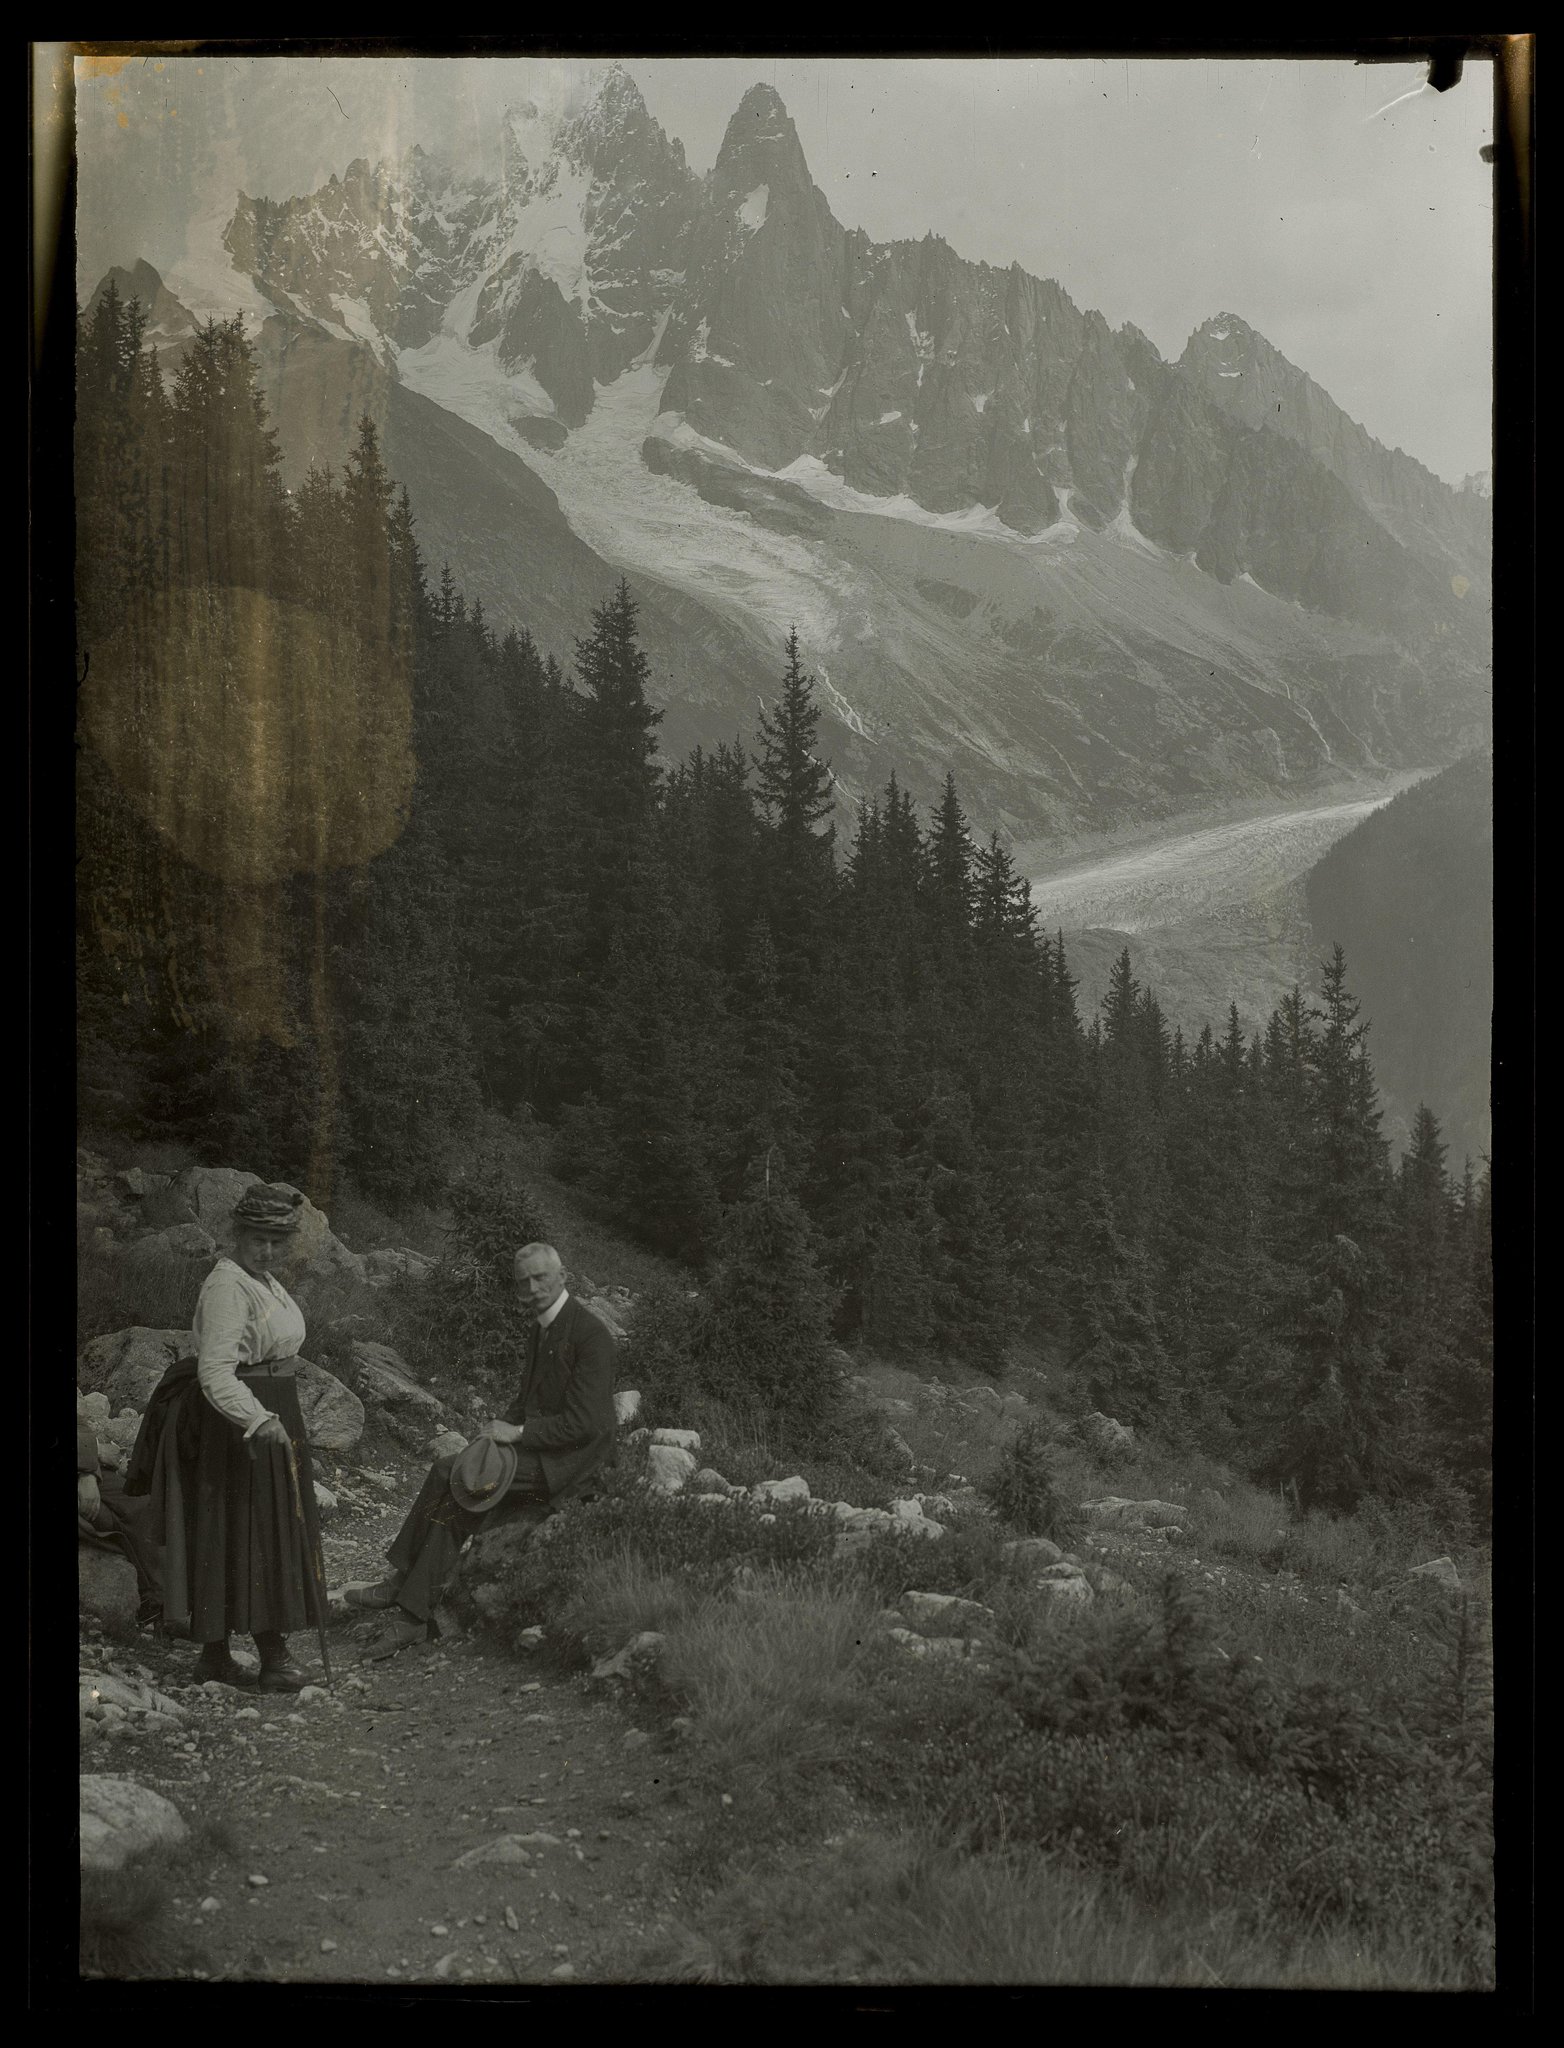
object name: photograph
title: Filmnegatief met opname van Basel, Thun, Kandersteg of Gemmi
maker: Anonymous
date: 1921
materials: film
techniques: gelatin silver negative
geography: switzerland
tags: switzerland